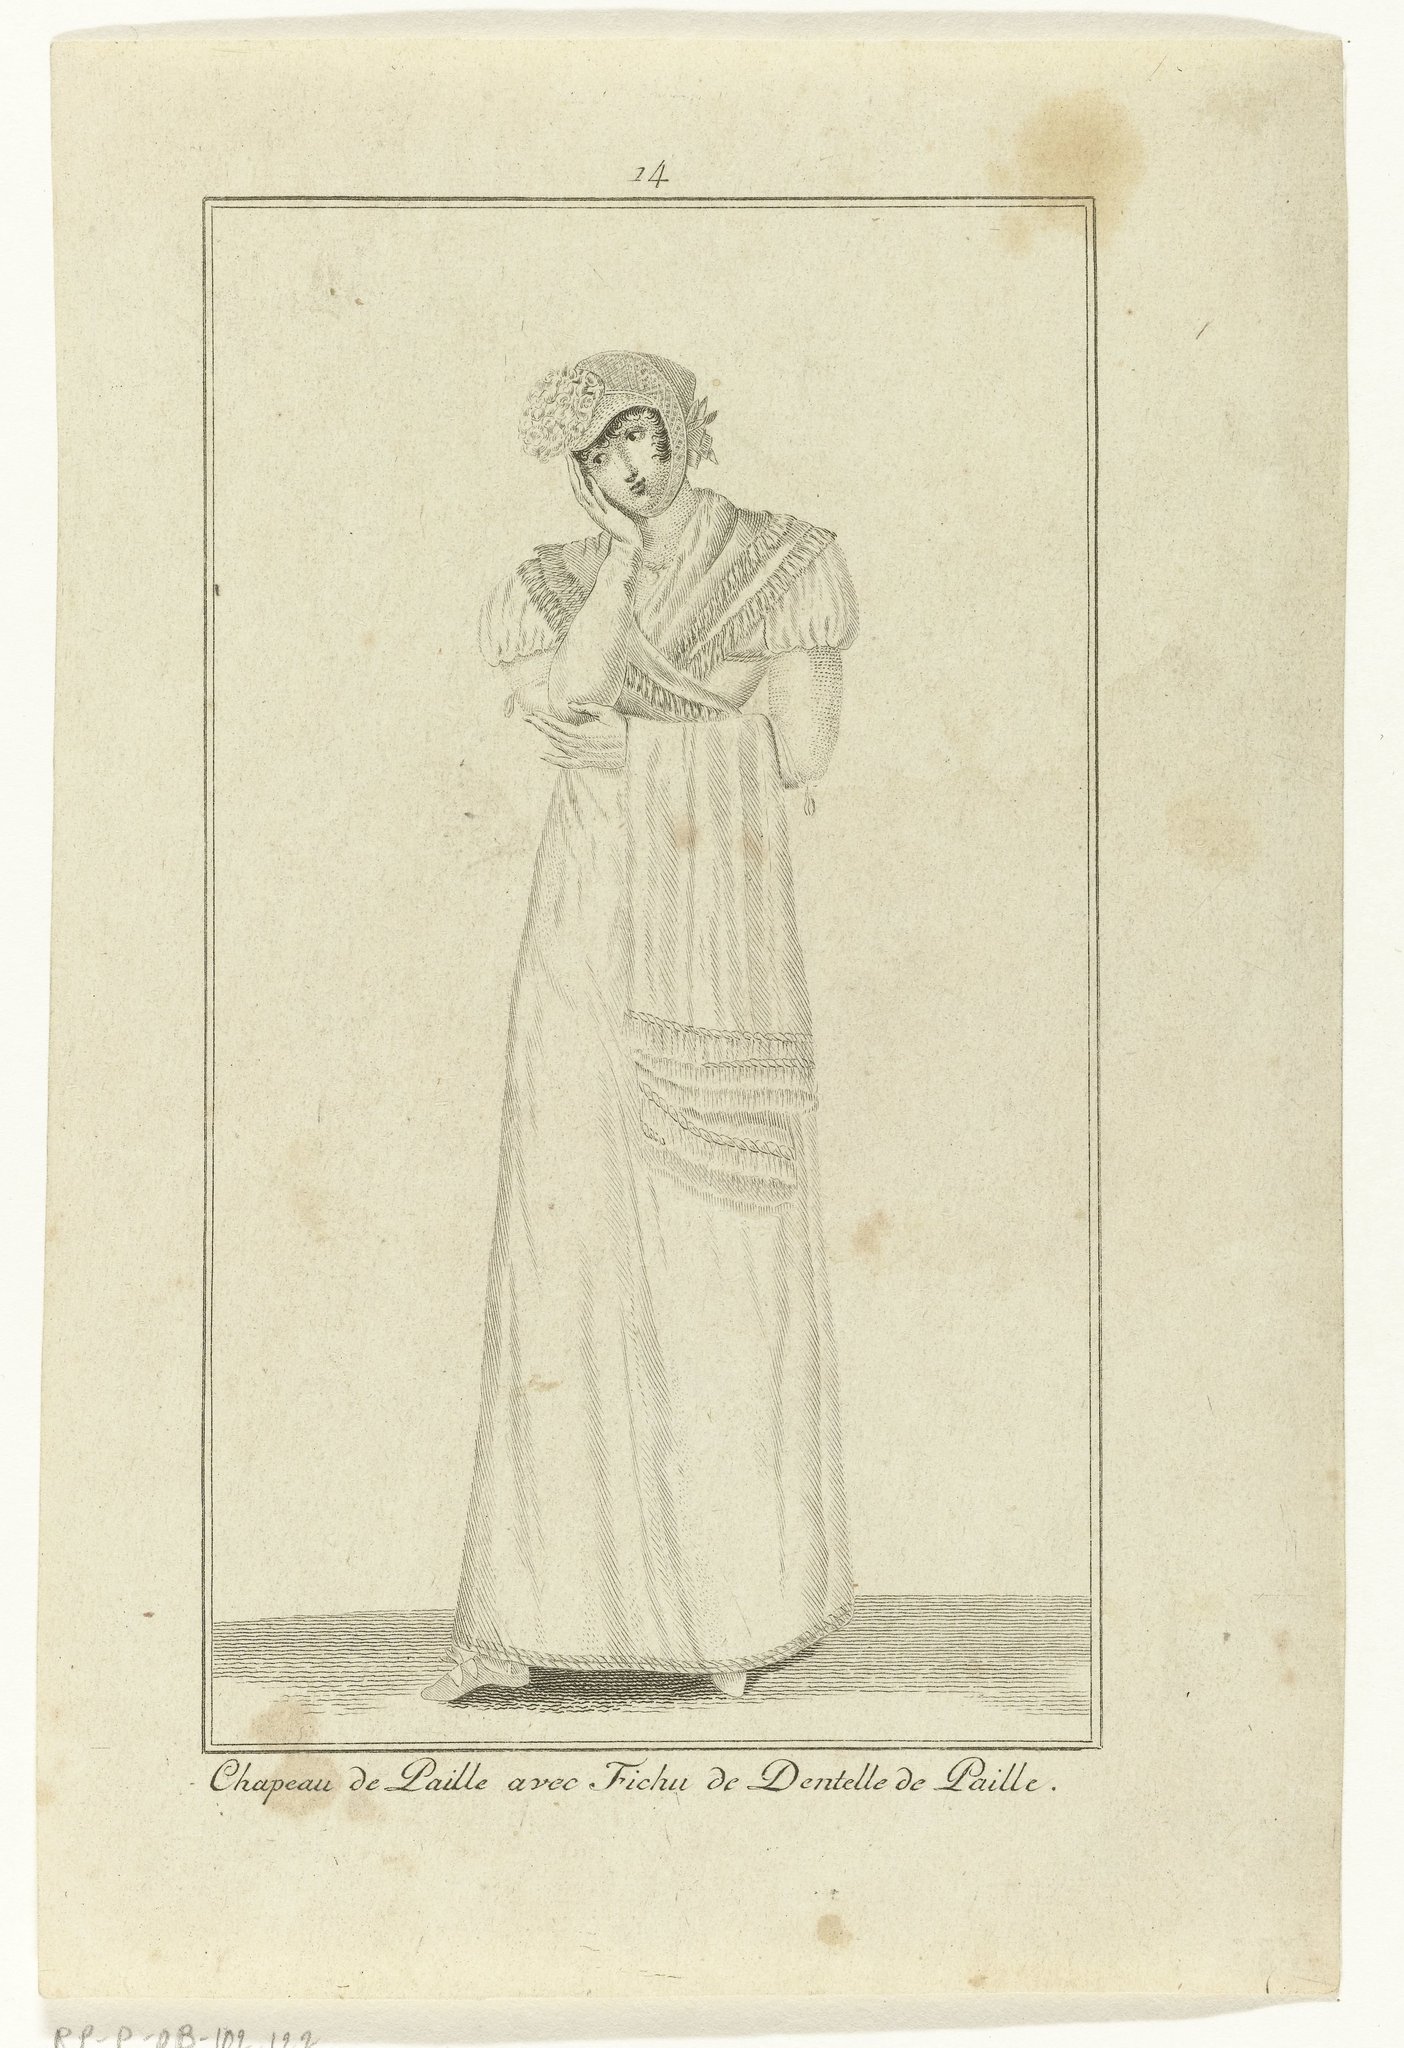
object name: fashion print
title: Elegantia, of tijdschrift van mode, luxe en smaak voor dames, Juni 1807, No. 14 : Chapeau de Paille...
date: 1807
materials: paper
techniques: engraving, hand coloring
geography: amsterdam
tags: gloves, mittens (long gloves) (+ women's clothes), clothing for the upper part of the body (shawl) (+ women's clothes), head-gear (straw hat) (+ women's clothes), fashion plates, shoes, sandals (+ women's clothes), dress, gown (+ women's clothes), piece of clothing covering the breast or décolleté (fichu) (+ women's clothes)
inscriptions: caption: ‘Chapeau de Paille avec Fichu de Dentelle de Paille’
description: Volgens de beschrijving in het tijdschrift (p. 200): Japon van mousseline. Strohoed gegarneerd met stro. 'Fichu Turc'. Sjaal, schoenen en 'touffe' op de strohoed van groene kasjmier. Prent uit het modetijdschrift Elegantia, of tijdschrift van mode, luxe en smaak voor dames 1807-1814 (onderbroken door de periode 1811-1813).